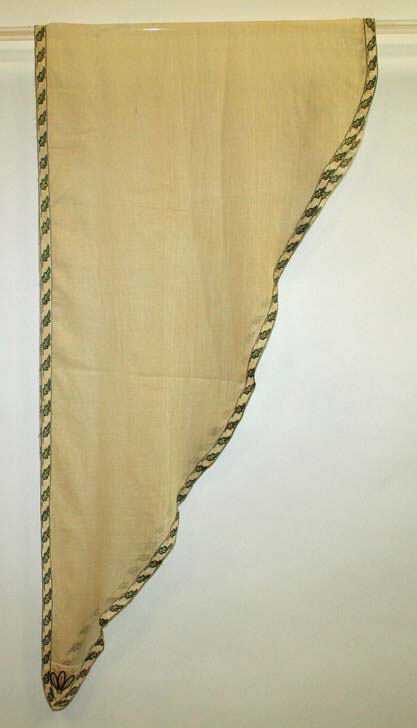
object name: scarf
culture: american or european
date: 1801-1833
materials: cotton